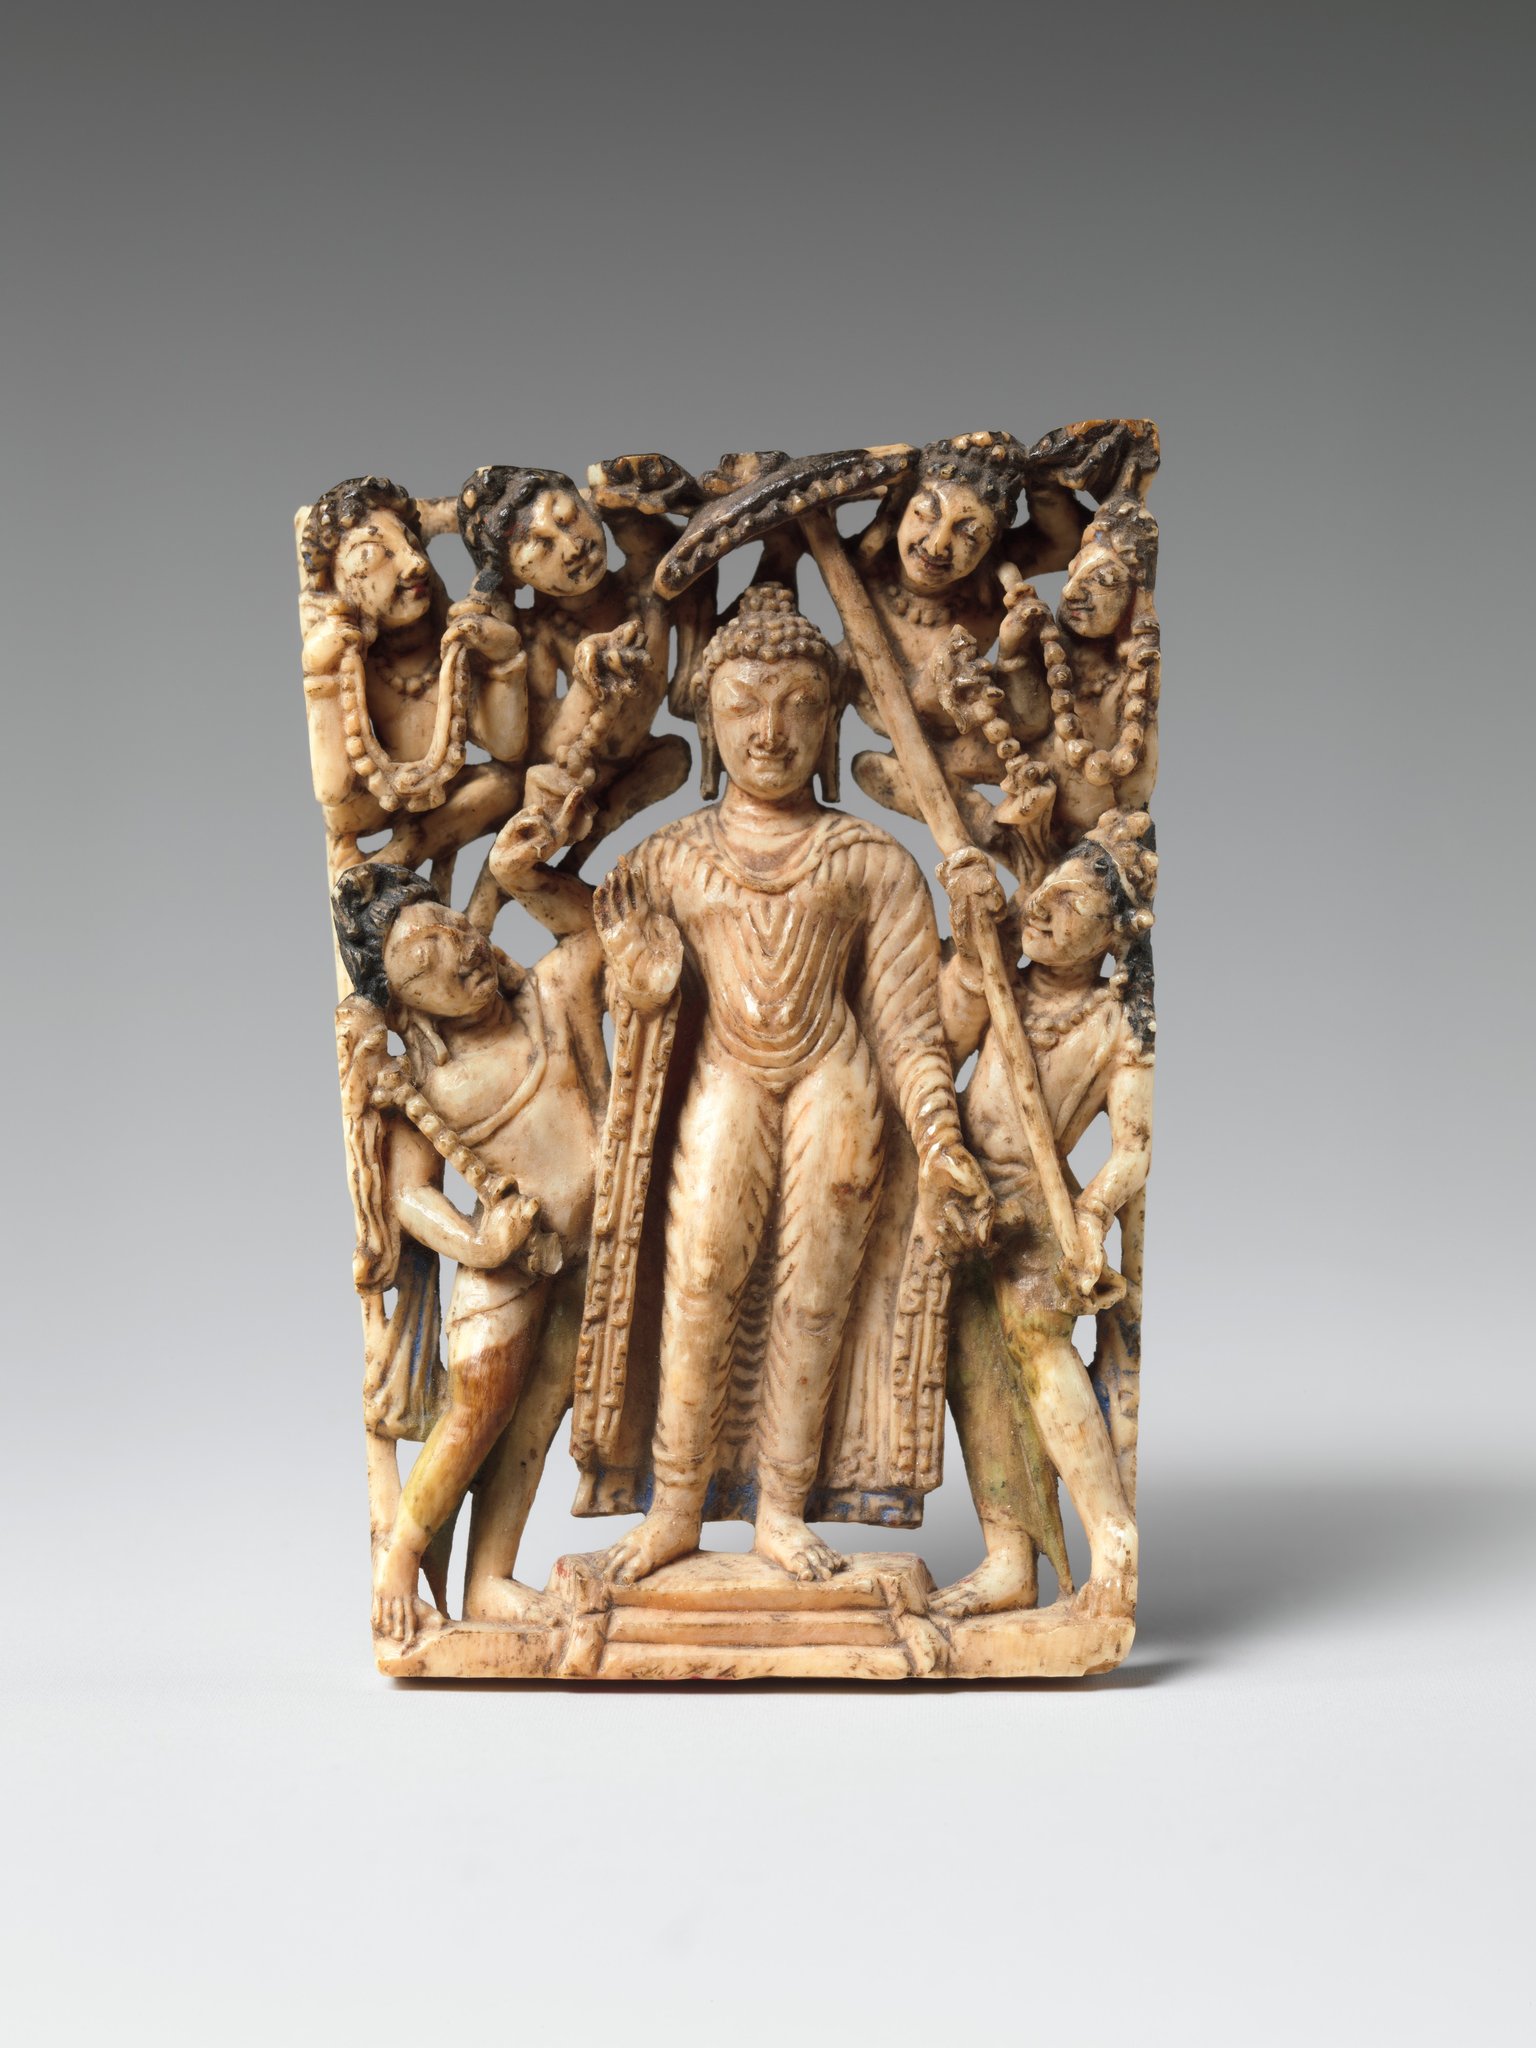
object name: portable shrine panel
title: Panel from a Portable Shrine: The Descent of the Buddha from Trayastrimsha Heaven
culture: indian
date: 601-800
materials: ivory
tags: kashmir,buddhism,buddha